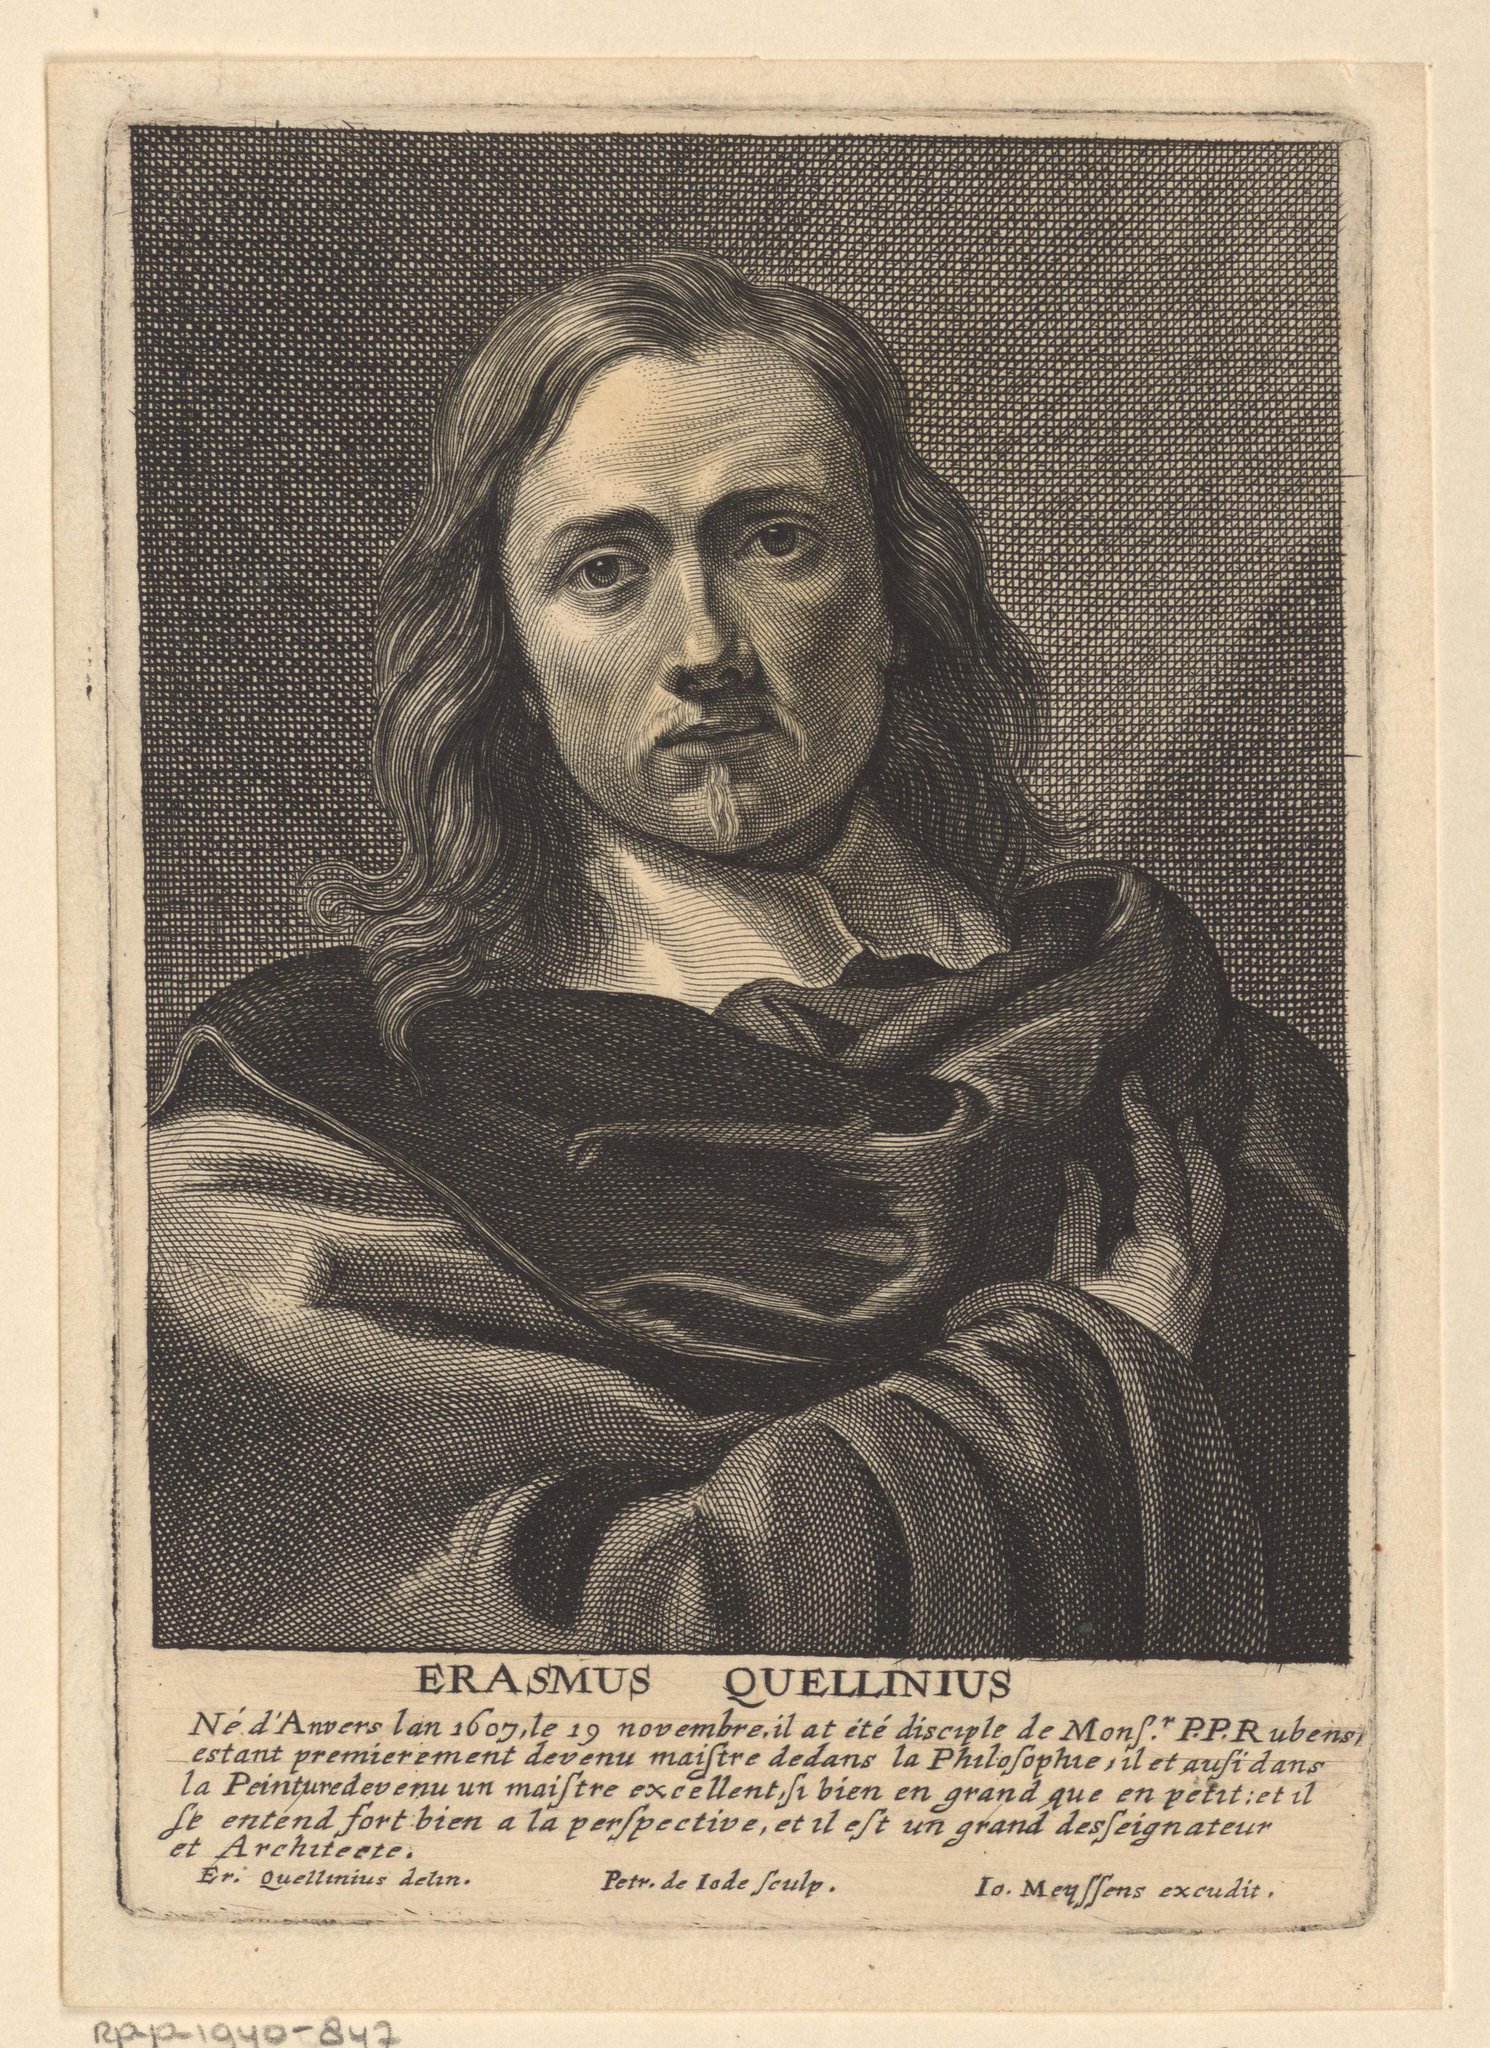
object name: print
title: Portret van Erasmus Quellinus II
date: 1640-1670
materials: paper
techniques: engraving, etching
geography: antwerp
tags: antwerp, print maker, draughtsman, erasmus quellinus (ii), historical persons, portrait, self-portrait of artist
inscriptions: collector's mark: Lugt 2760, collector's mark: Lugt 2228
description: Prent later gebruikt in: The Portraits of the Most Eminent Painters, and Other Famous Artists, that Have Flourished in Europe. Londen: Olive Payne, 1739.